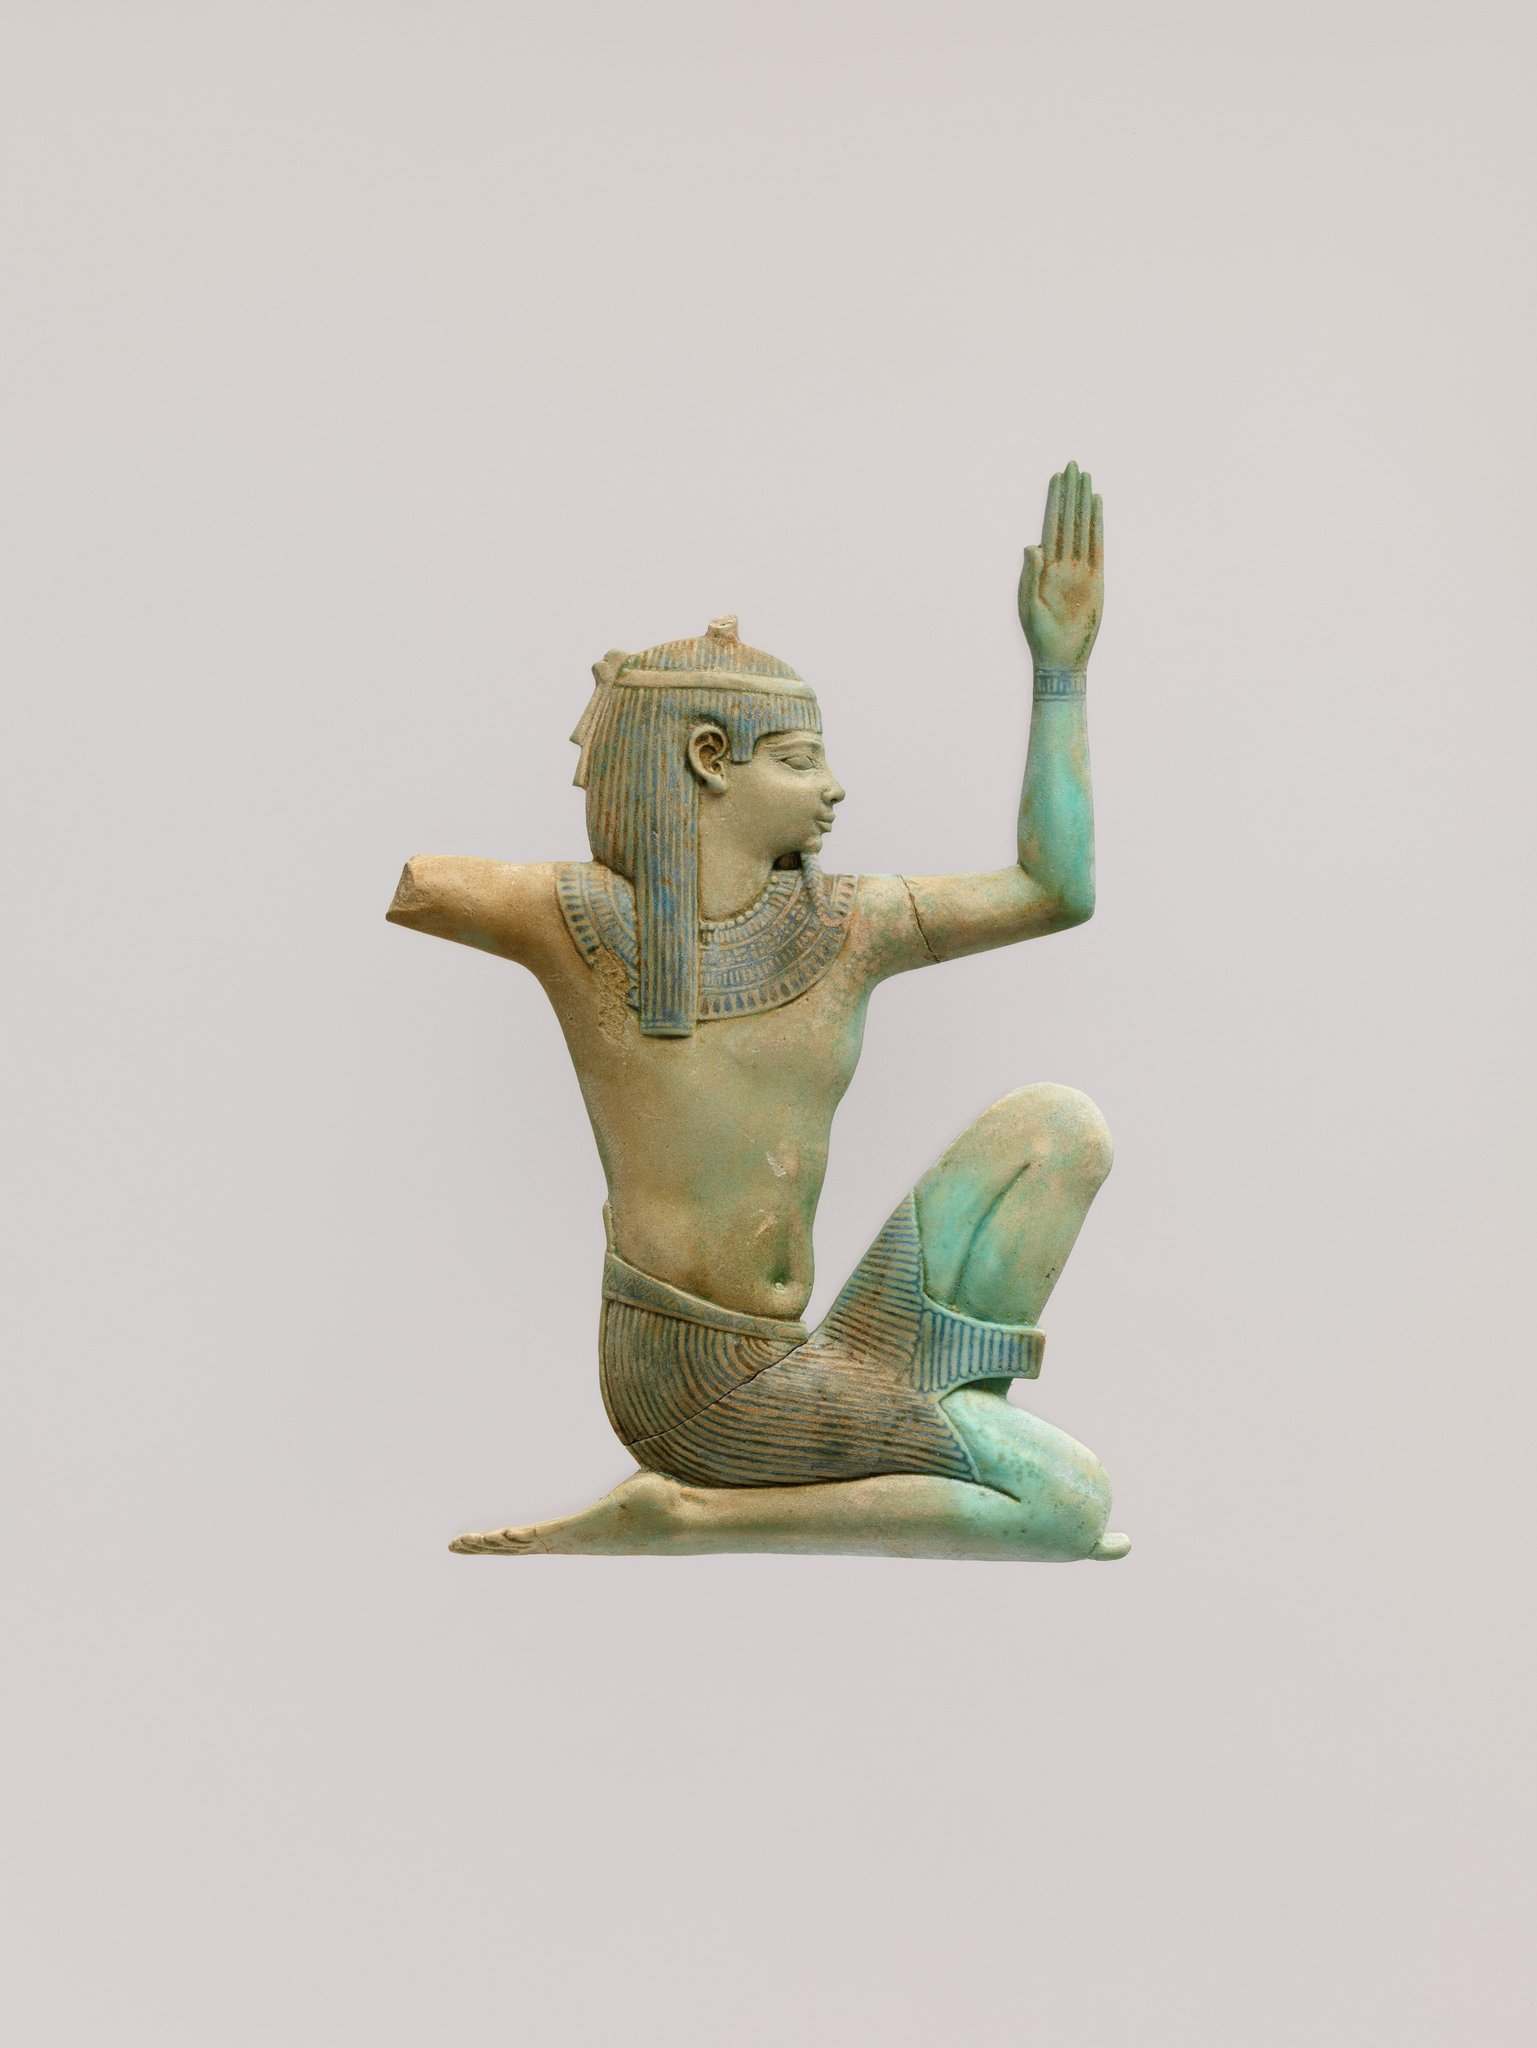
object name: inlay, hieroglyphic, heh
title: Inlay of the hieroglyphic sign "heh" meaning "millions of years"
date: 400-301 BCE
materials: faience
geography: middle egypt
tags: men